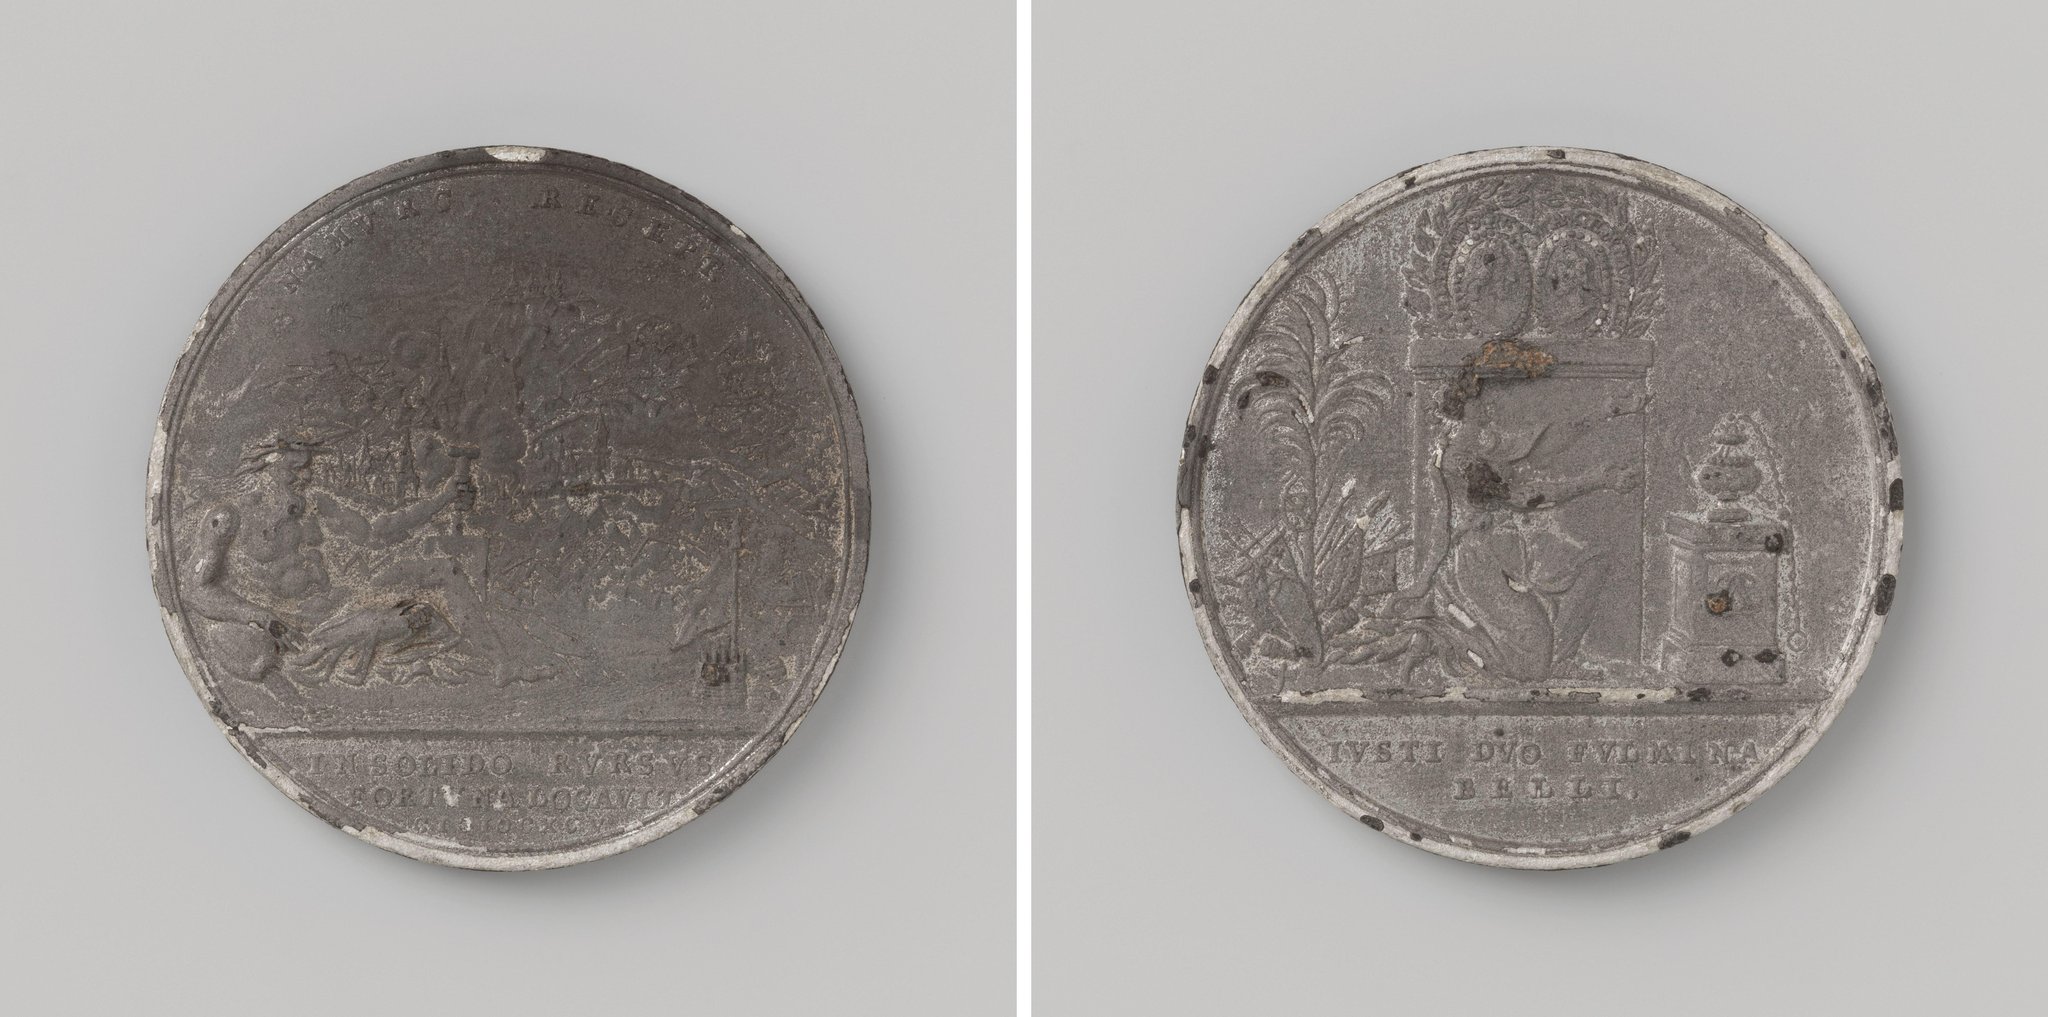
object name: copy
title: Herovering van Namen door Willem III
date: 1695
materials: tin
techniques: striking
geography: amsterdam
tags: william iii (prince of orange and king of england, scotland, and ireland), maximiliaan ii emanuel (keurvorst van beieren)